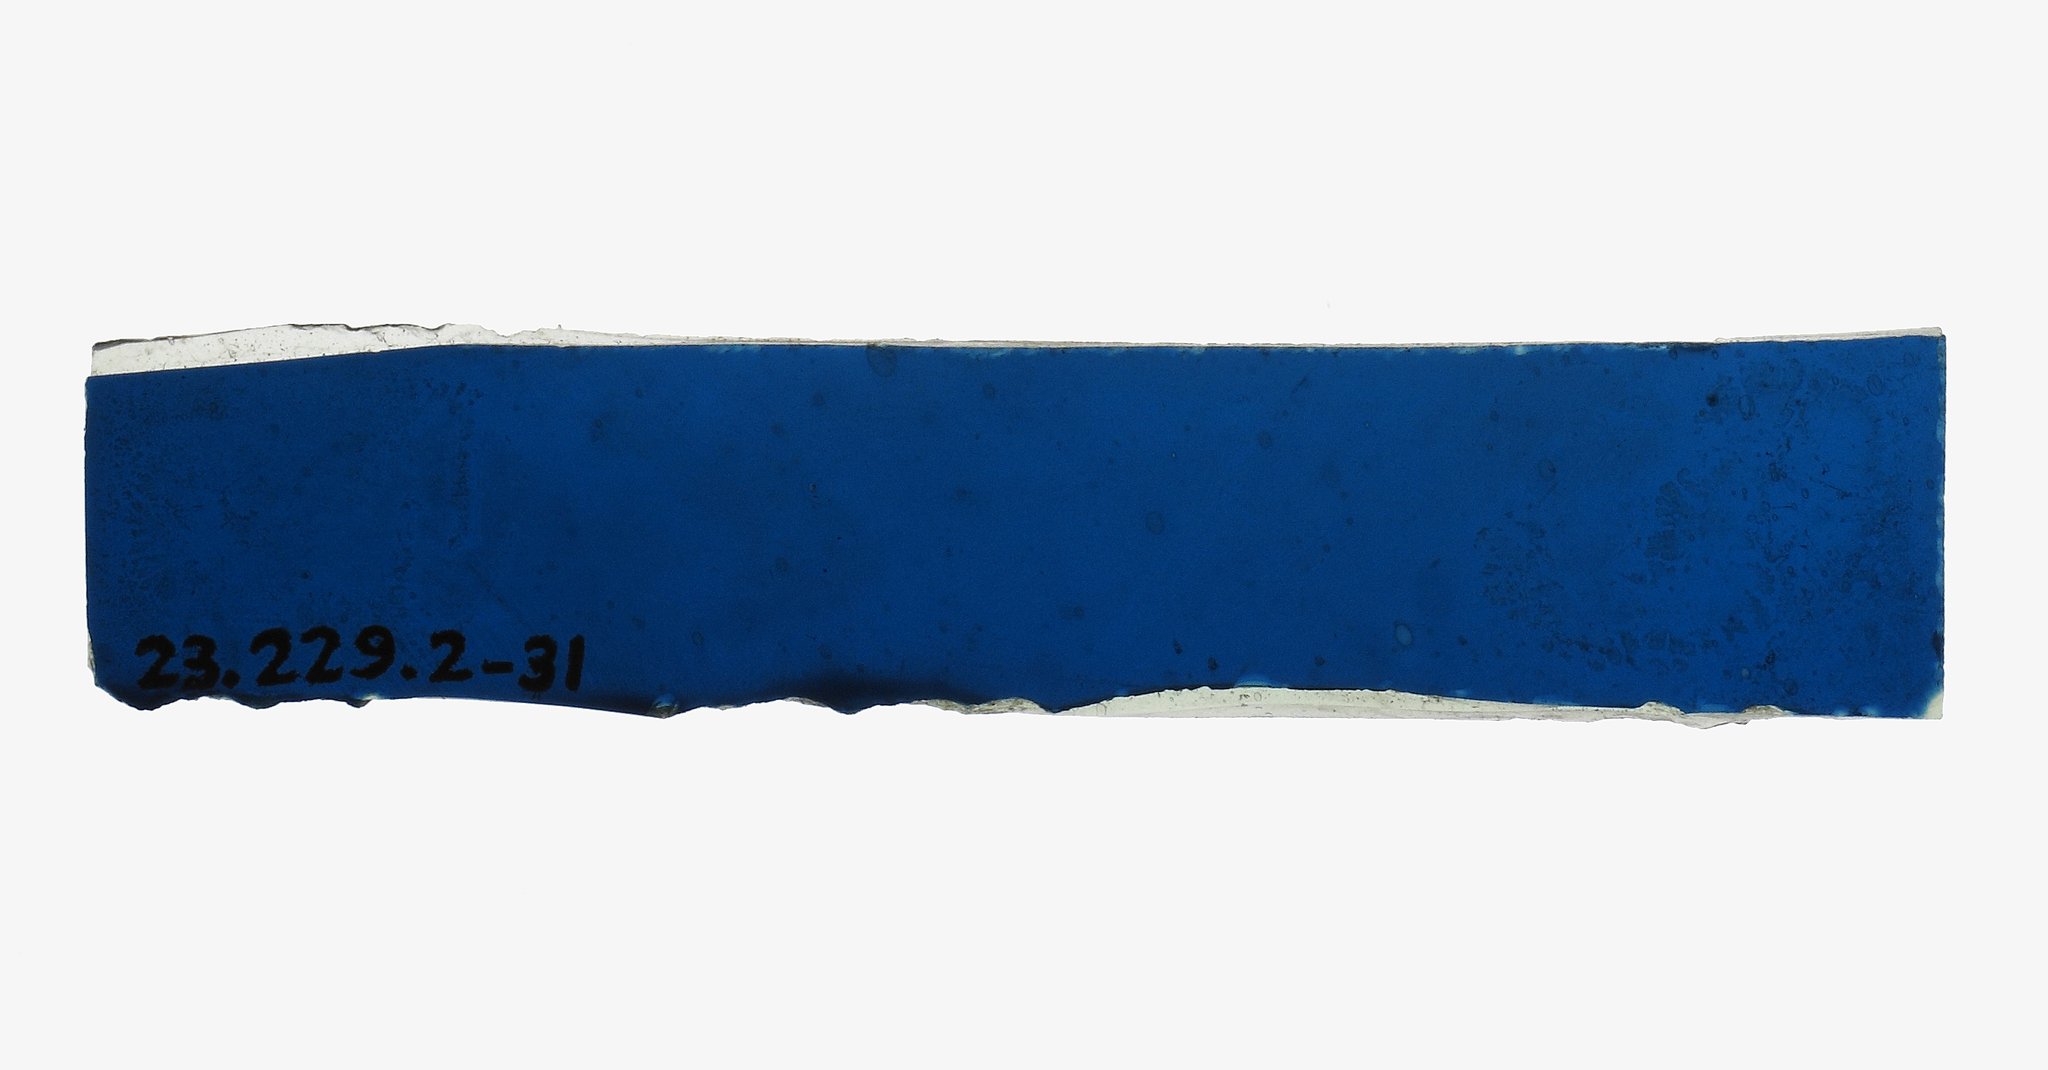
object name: fragment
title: Glass Fragment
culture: british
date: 1801-1900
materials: glass